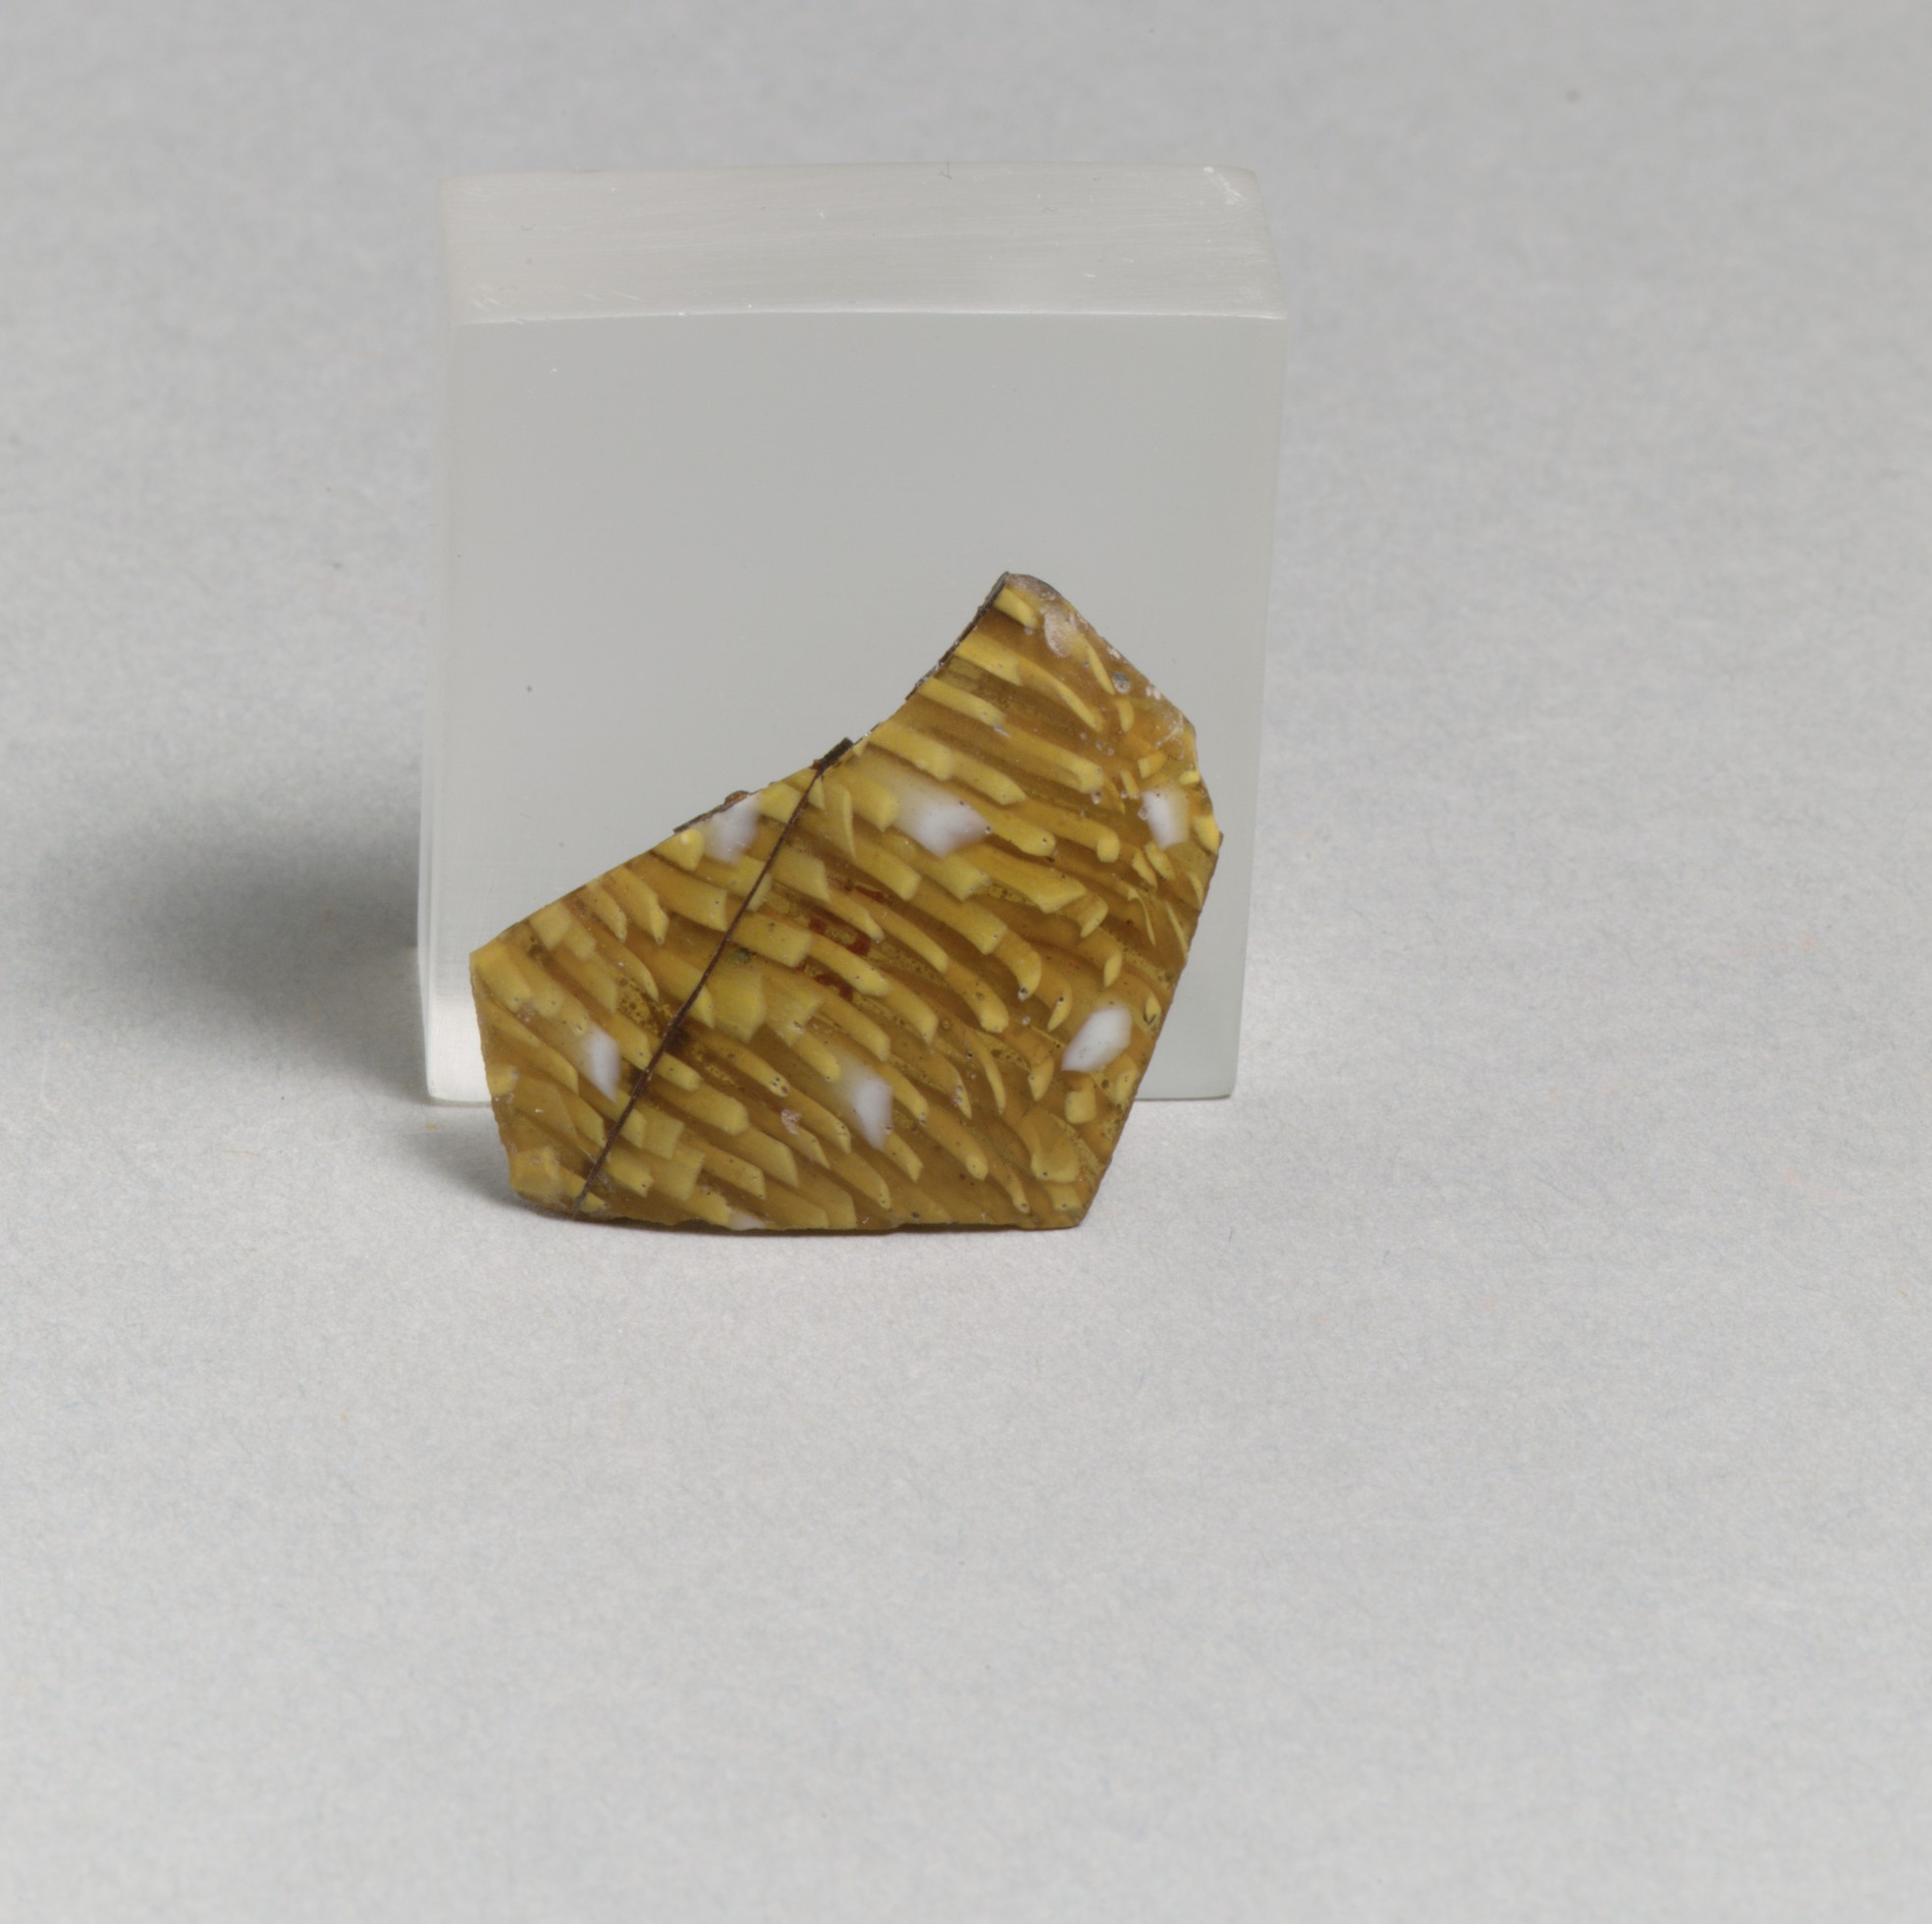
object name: fragment, mosaic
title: Glass mosaic fragment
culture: roman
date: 34 BCE-33 CE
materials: glass